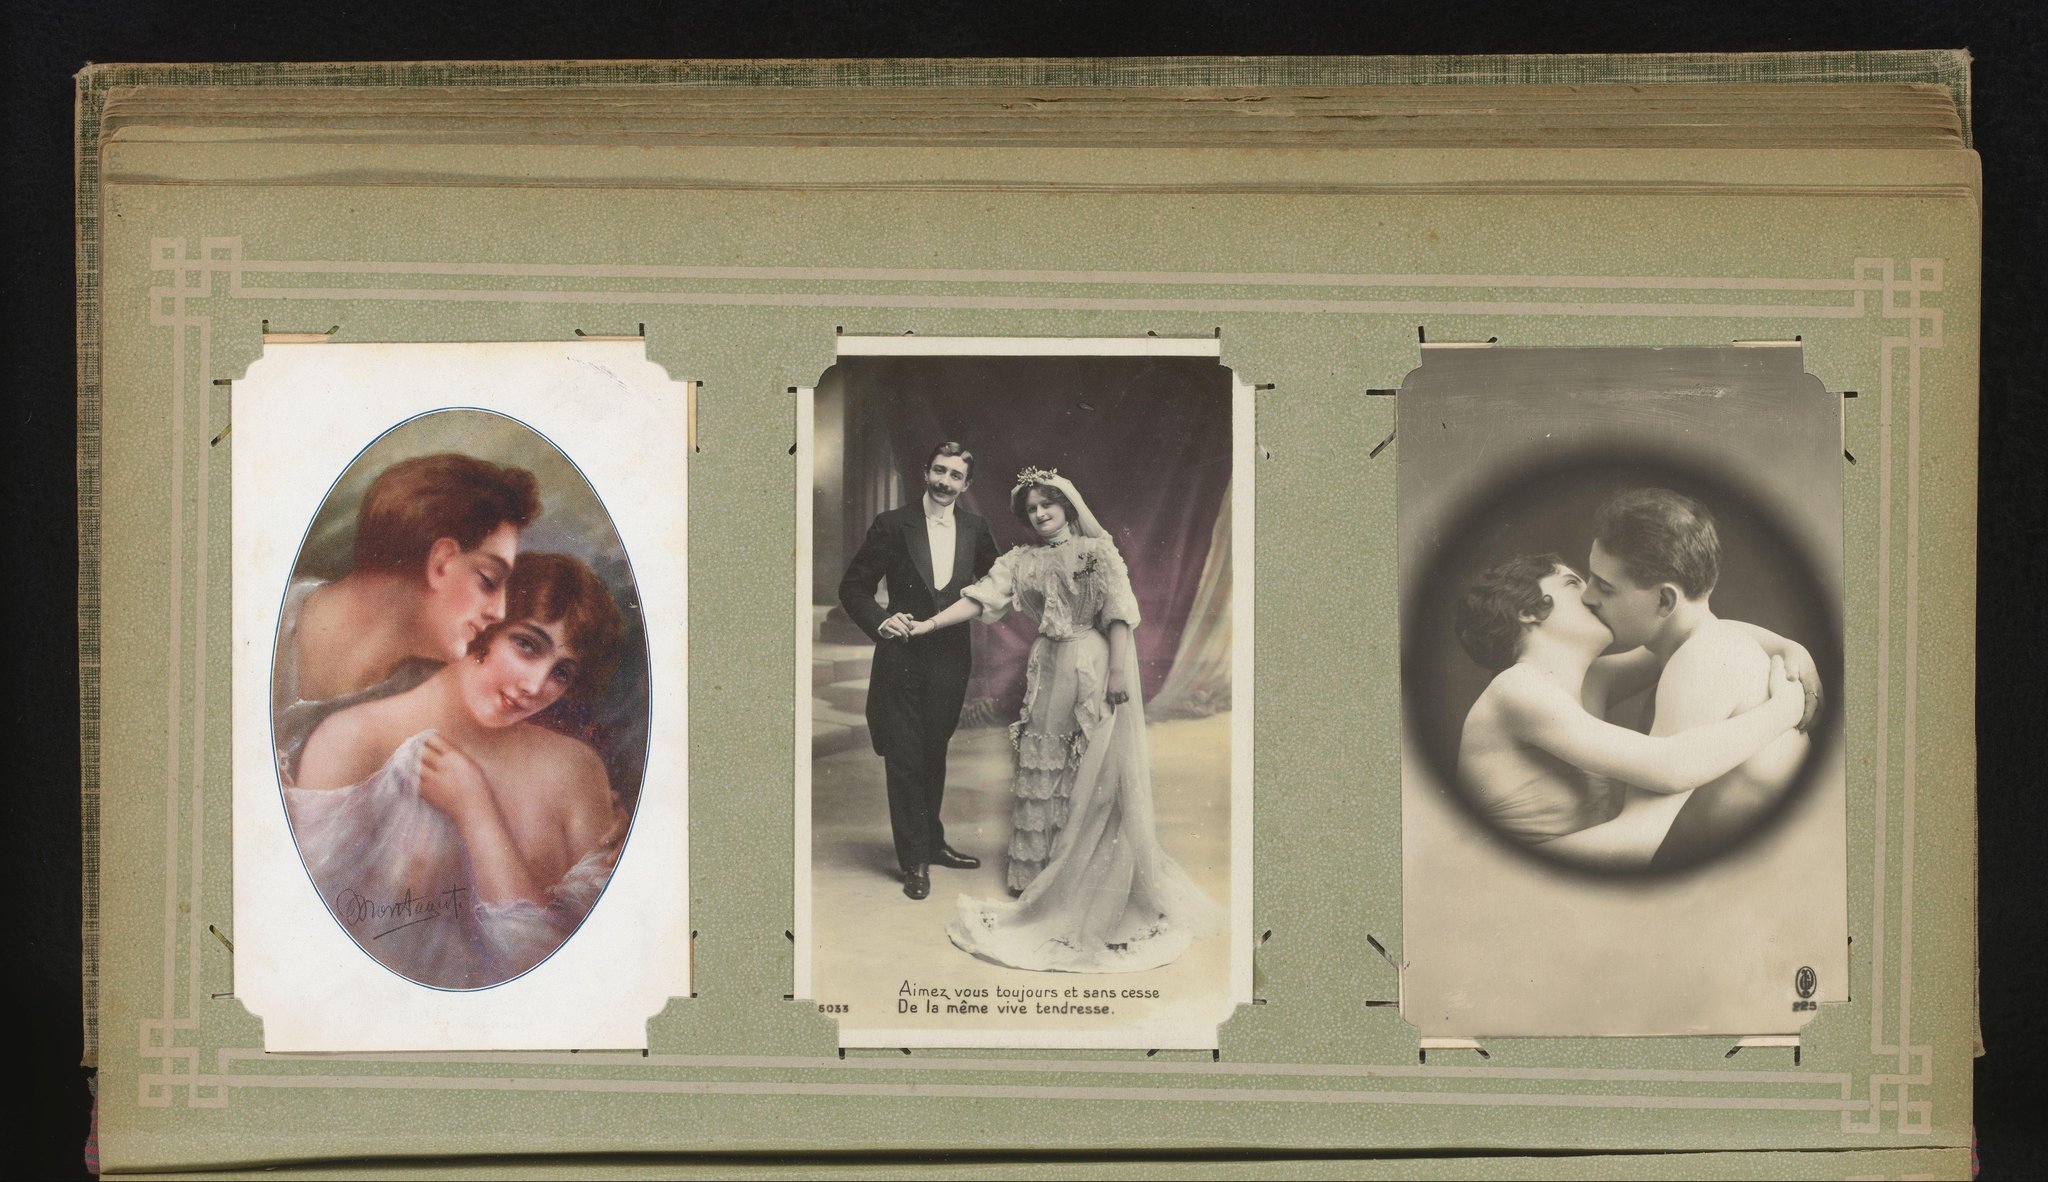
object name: reproduction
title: Drie portretten van geliefden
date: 1900-1930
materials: cardboard, photographic support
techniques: gelatin silver print, hand coloring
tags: bride and groom in wedding-dress, couple of lovers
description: Een reproductie van een schilderij van een paar geliefden, een foto van een paar in bruidskleding en een foto van een kussend paar. Deze foto's en prent maken deel uit van een album.